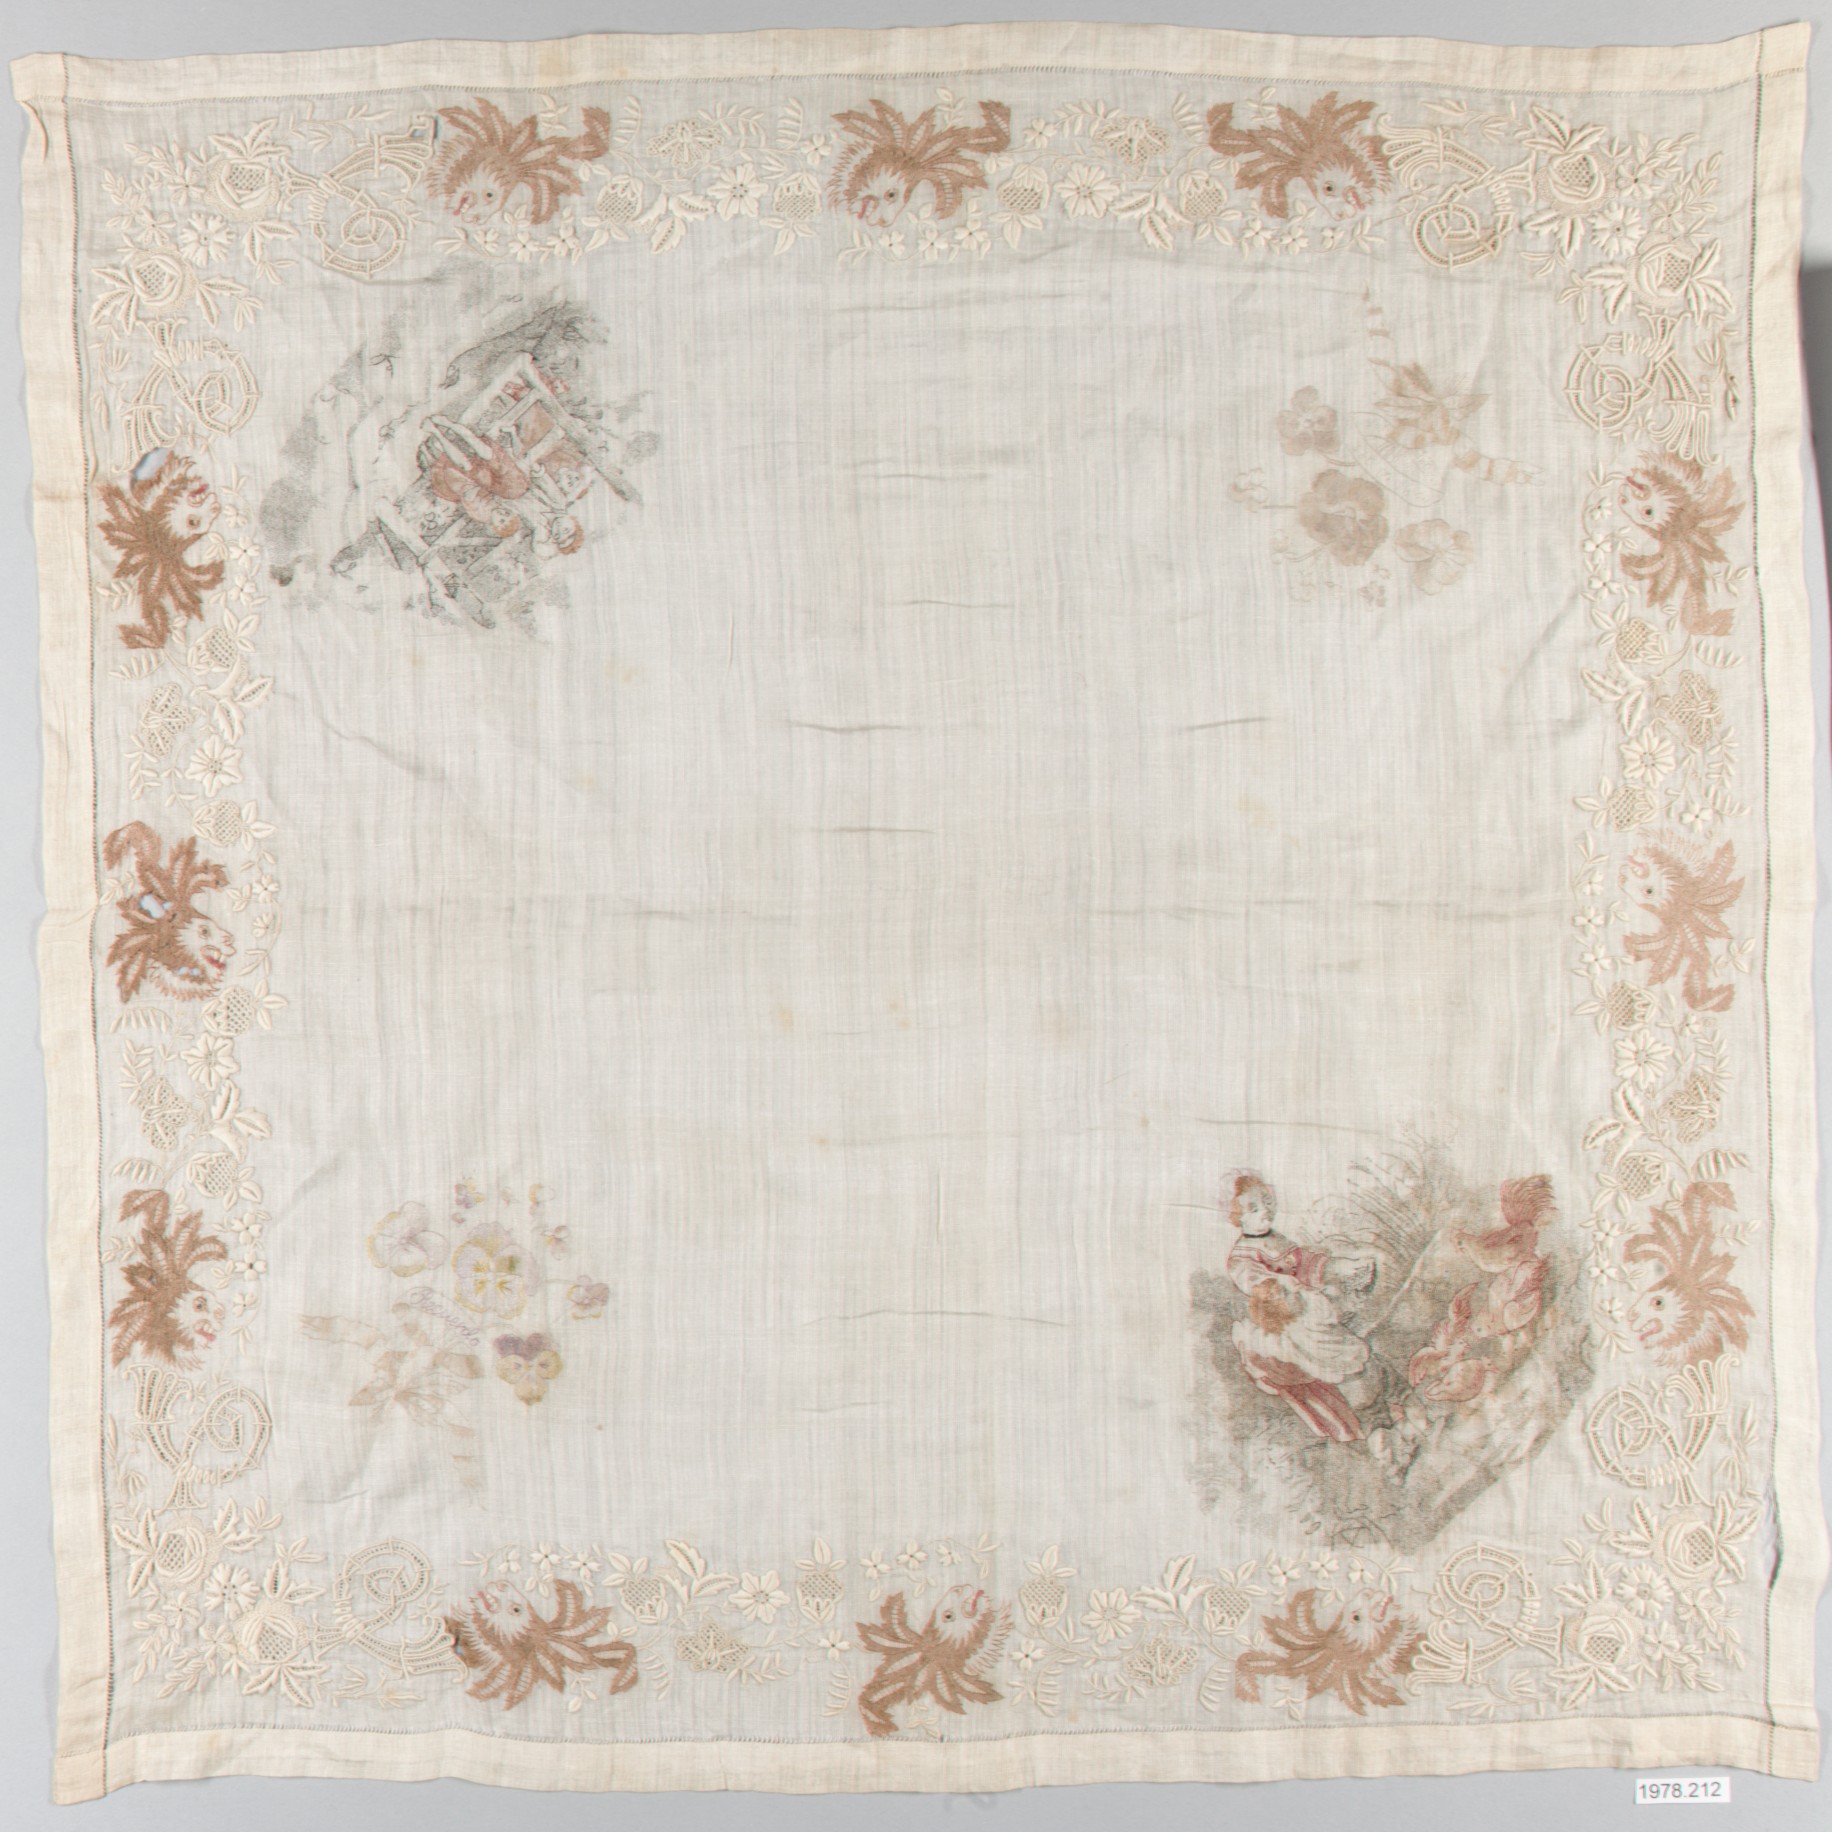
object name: handkerchief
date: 1801-1900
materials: linen, silk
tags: chickens,children,women,flowers